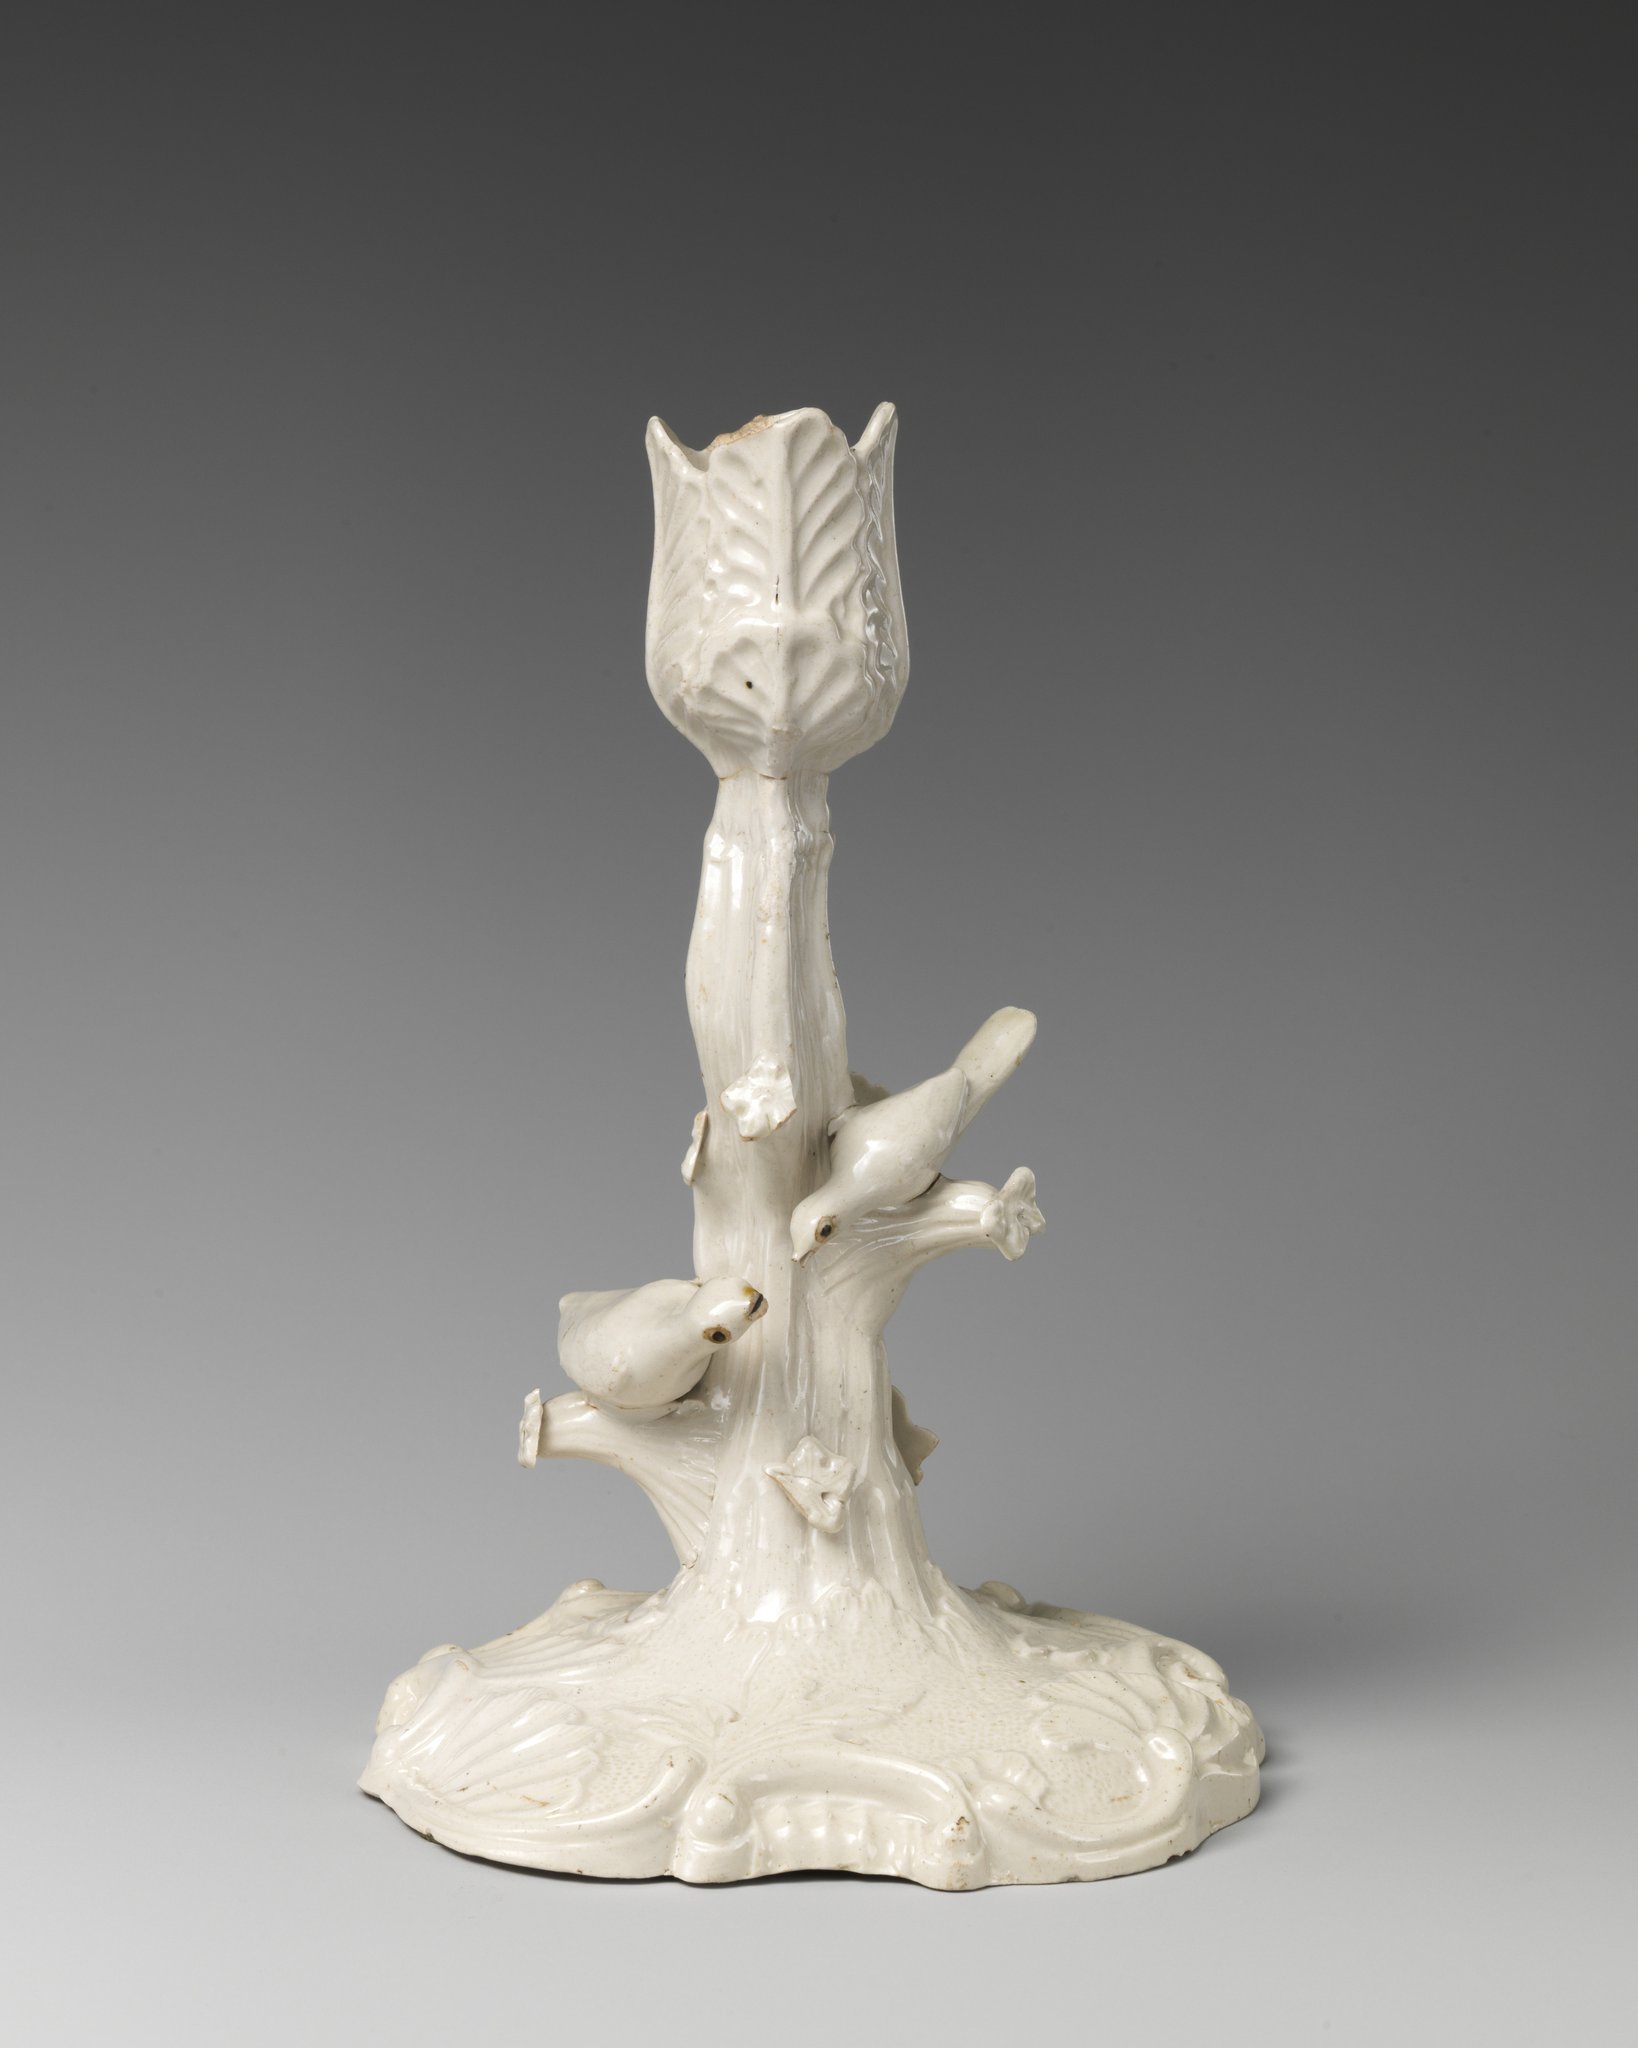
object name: candlestick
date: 1760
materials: stoneware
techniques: salt glaze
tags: birds